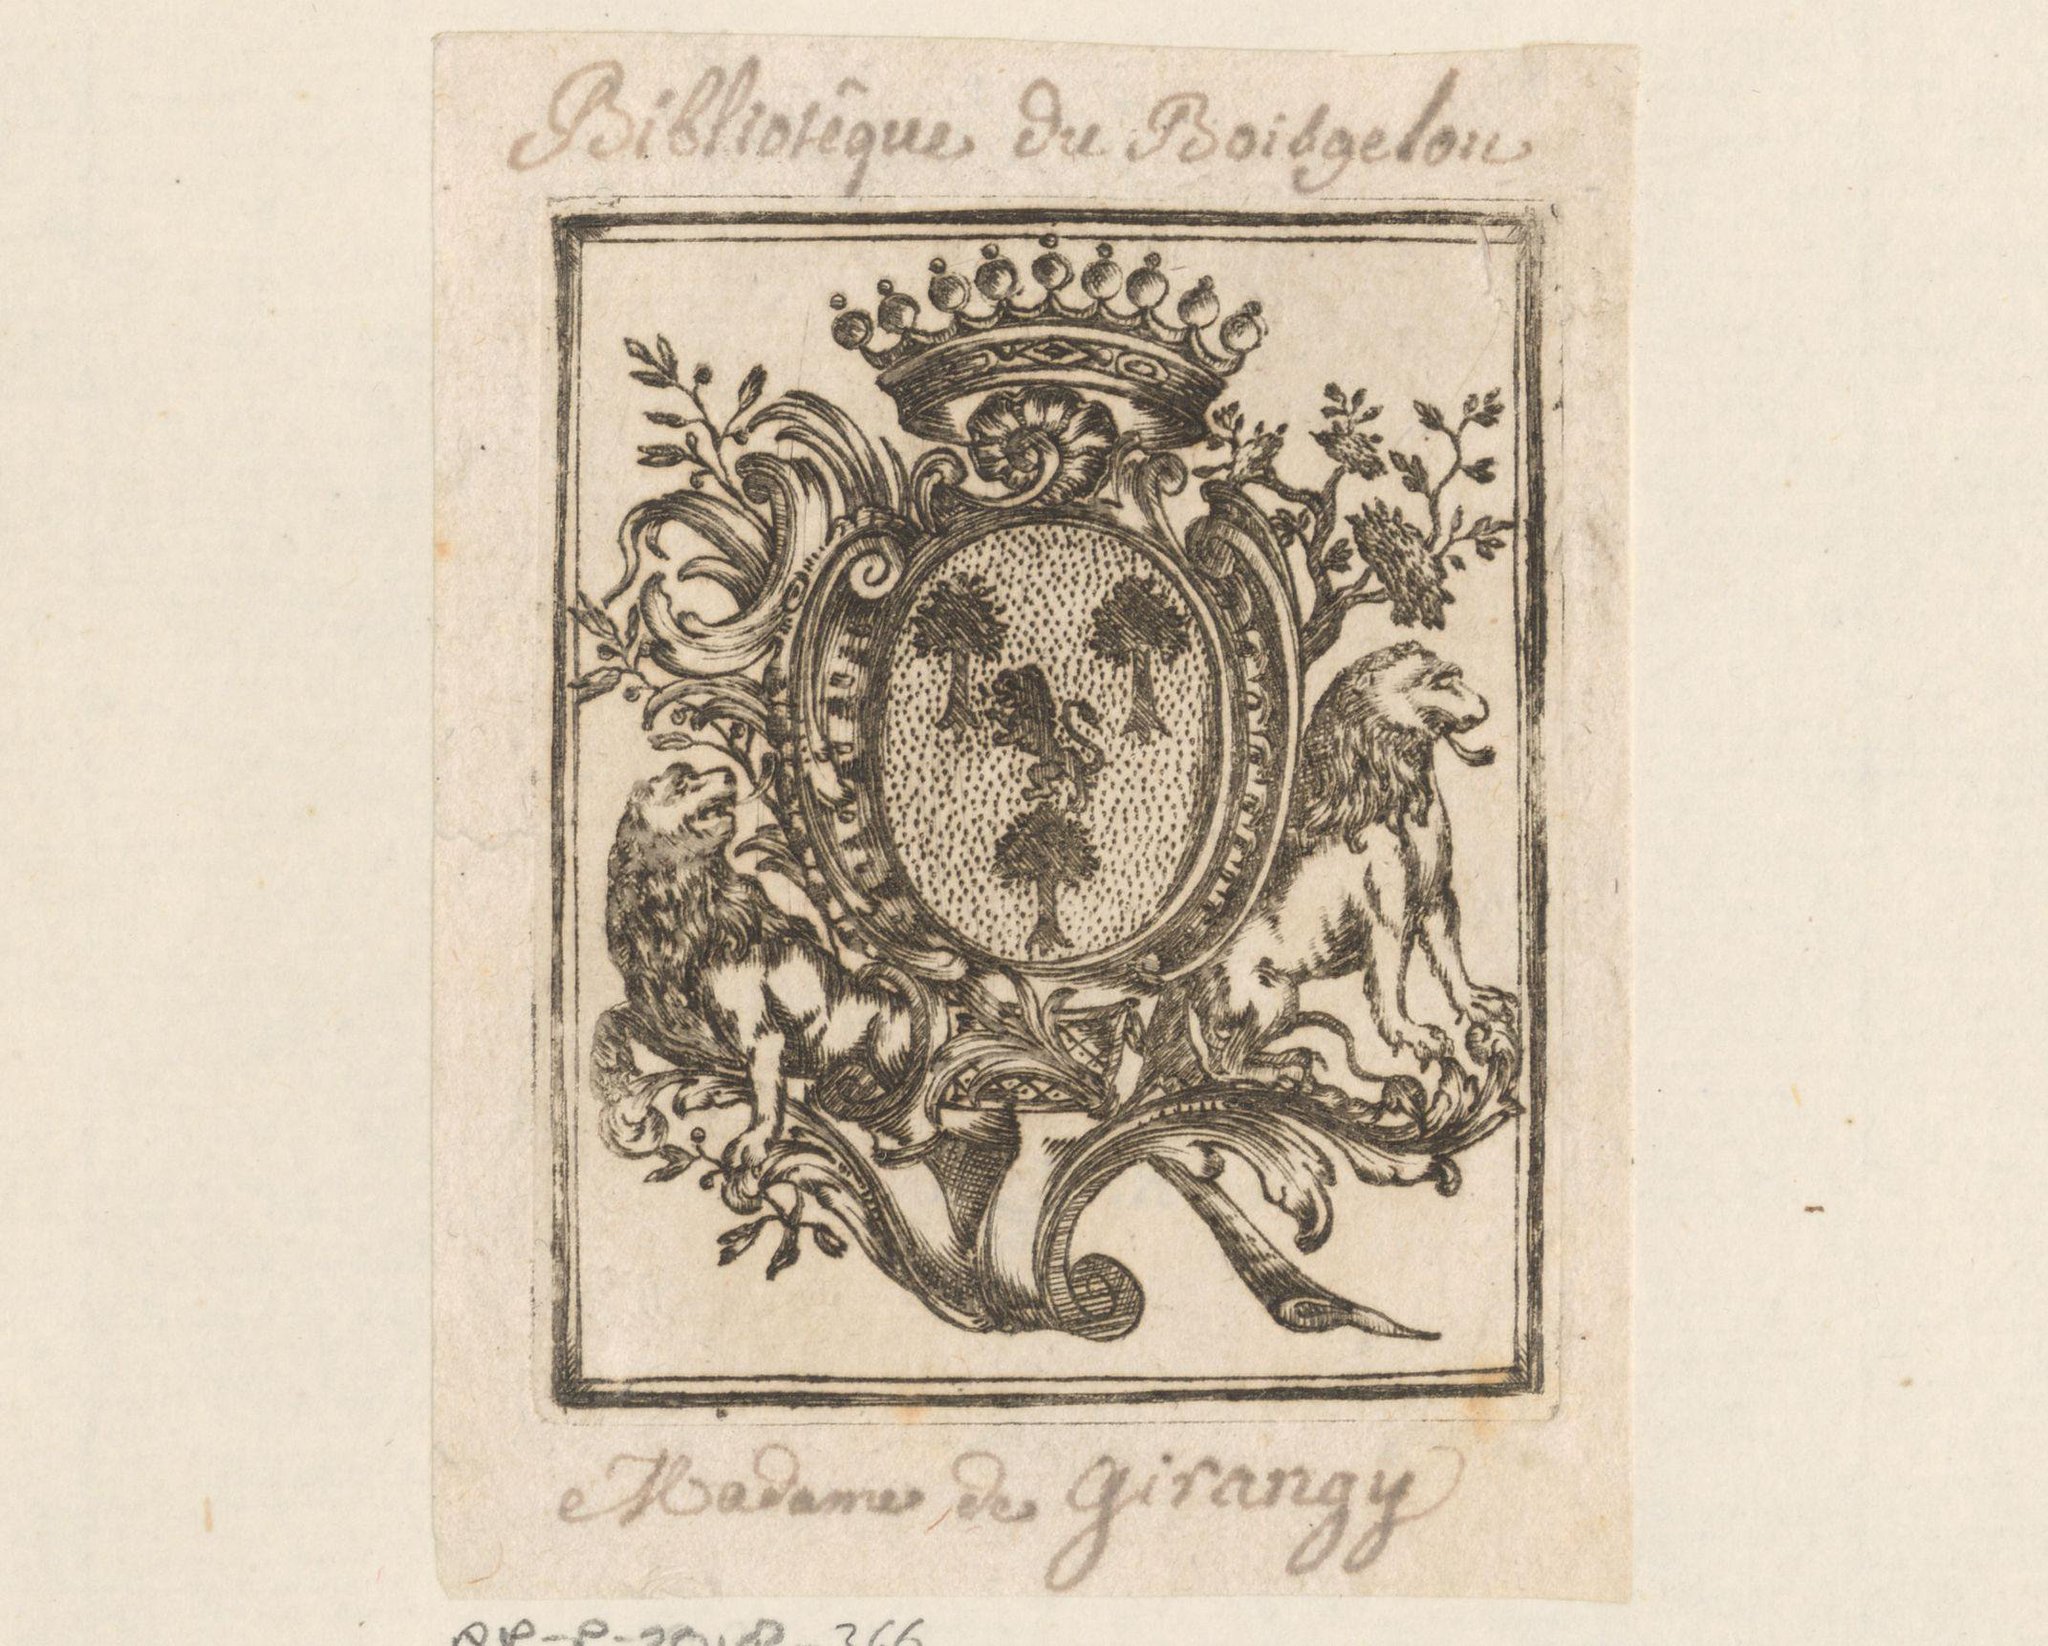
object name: bookplate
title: Ex libris van Marie Catherine Le Bas de Girangy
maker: Anonymous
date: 1706-1742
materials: paper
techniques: etching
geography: france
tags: paris, trees, beasts of prey, predatory animals: lion, armorial bearing, heraldry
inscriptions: collector's mark: Lugt 2233, inscription: ‘Bibliothèque du Boisgelou [?]/ Madame de Girangy’, collector's mark: Lugt 2760